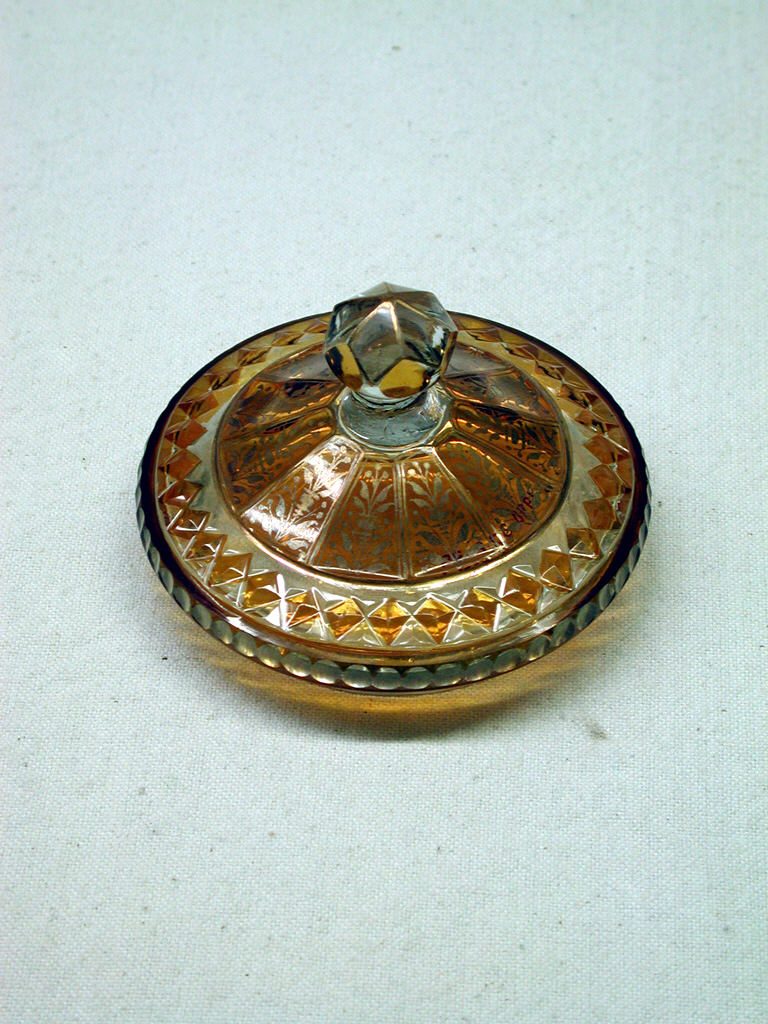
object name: cover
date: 1850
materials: glass